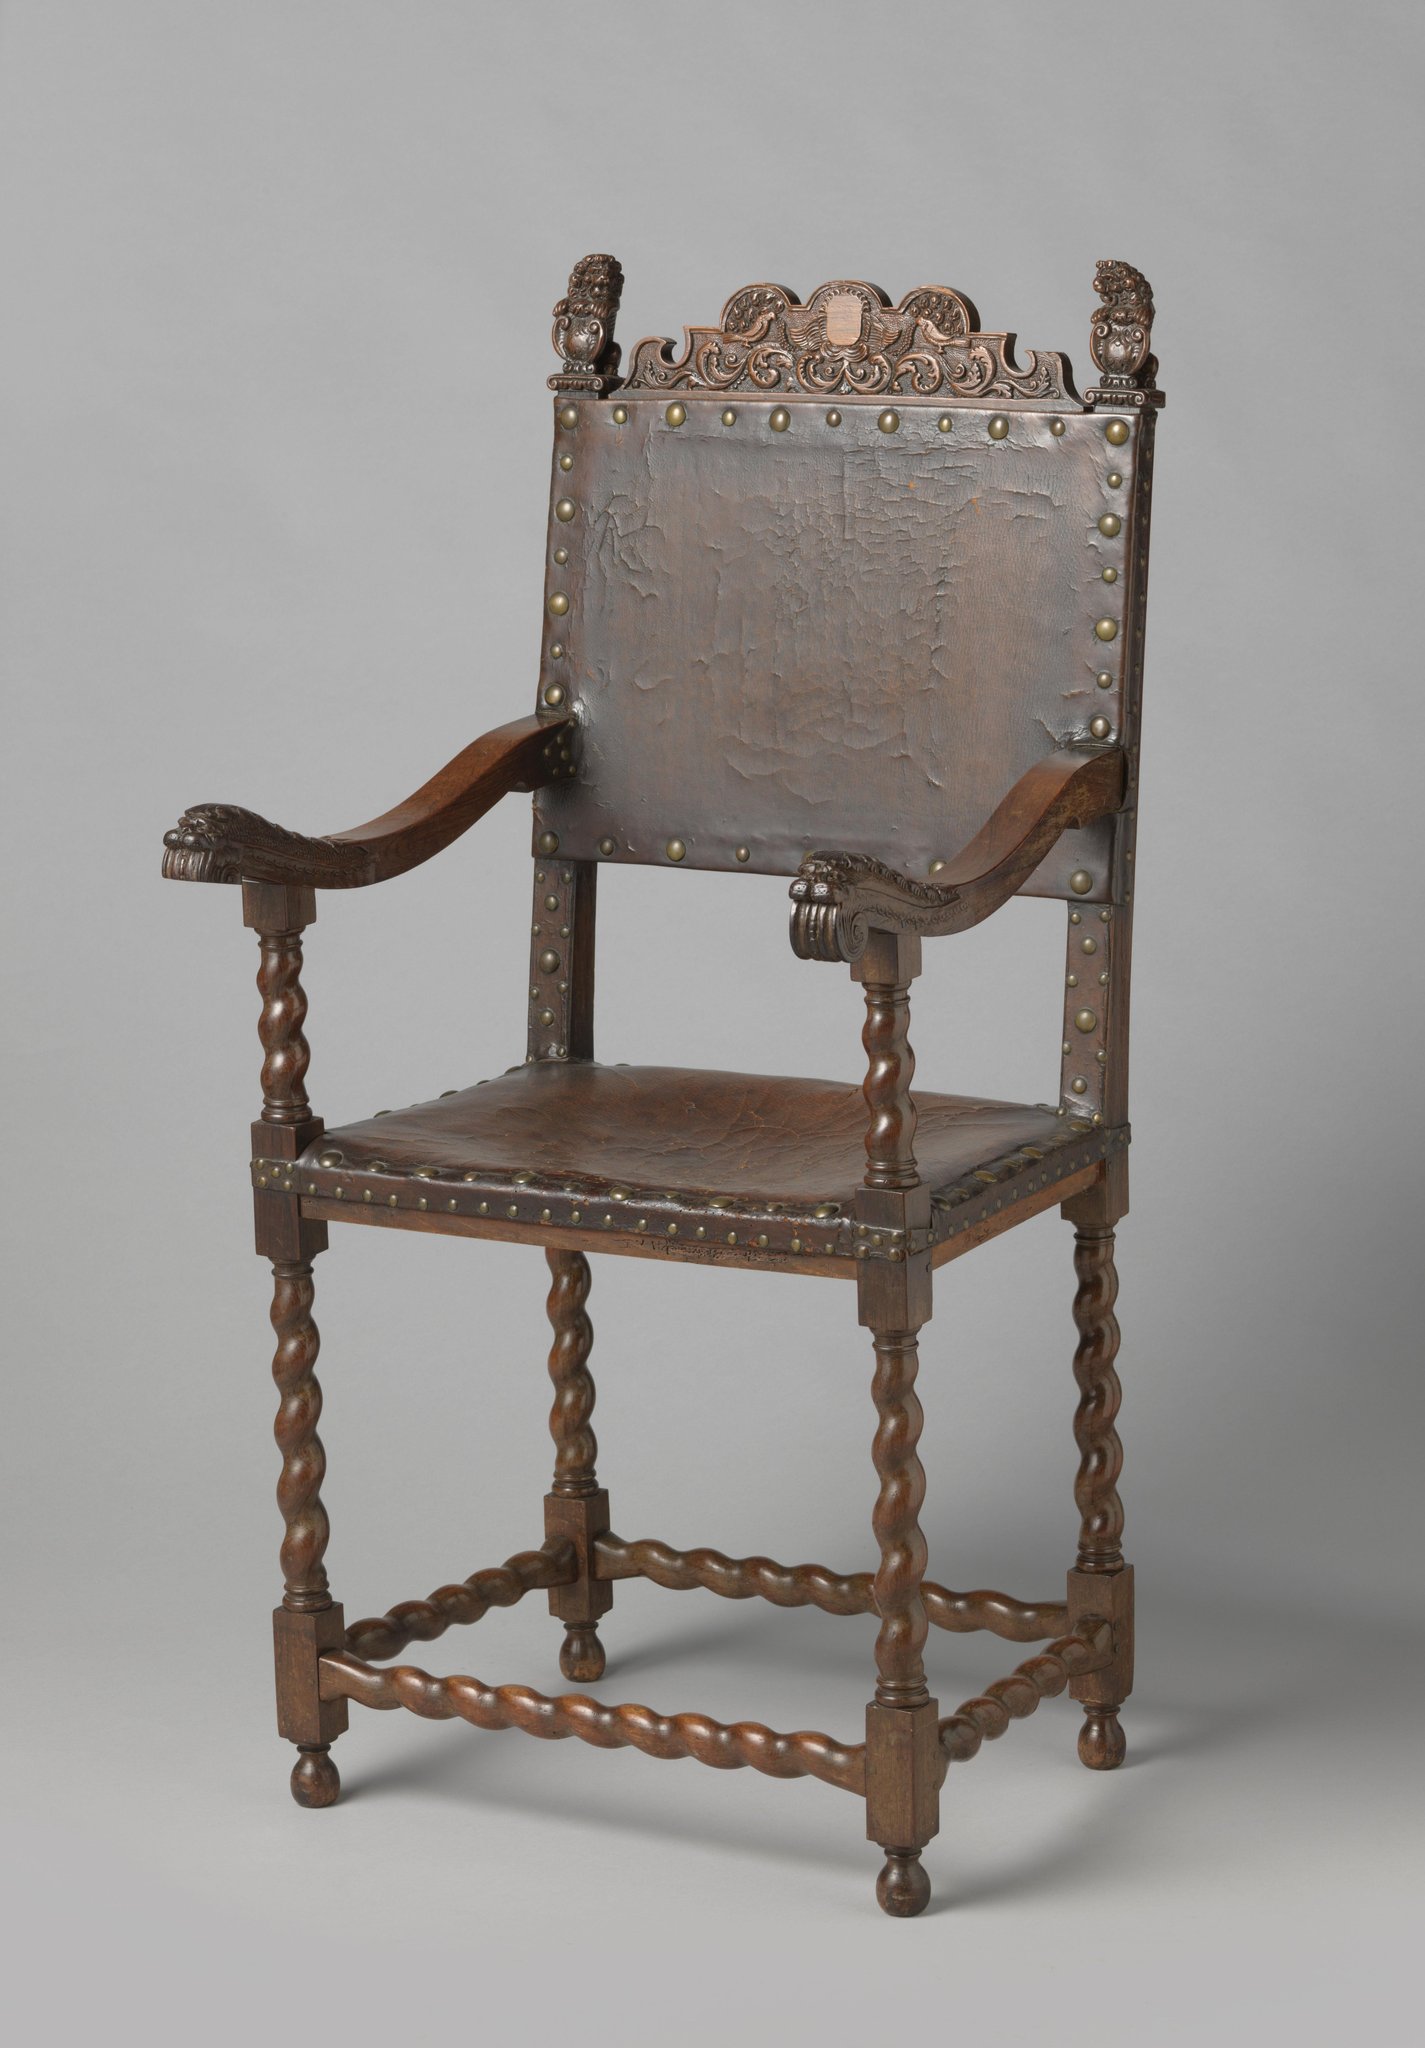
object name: chair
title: Armstoel van palissanderhout met leer bekleed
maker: Anonymous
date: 1625-1650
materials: hair, leather, wood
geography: northern netherlands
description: Armchair. Rosewood. Netherlands, c. 1625 - 1650. On loan from the Koninklijk Oudheidkundig Genootschap.